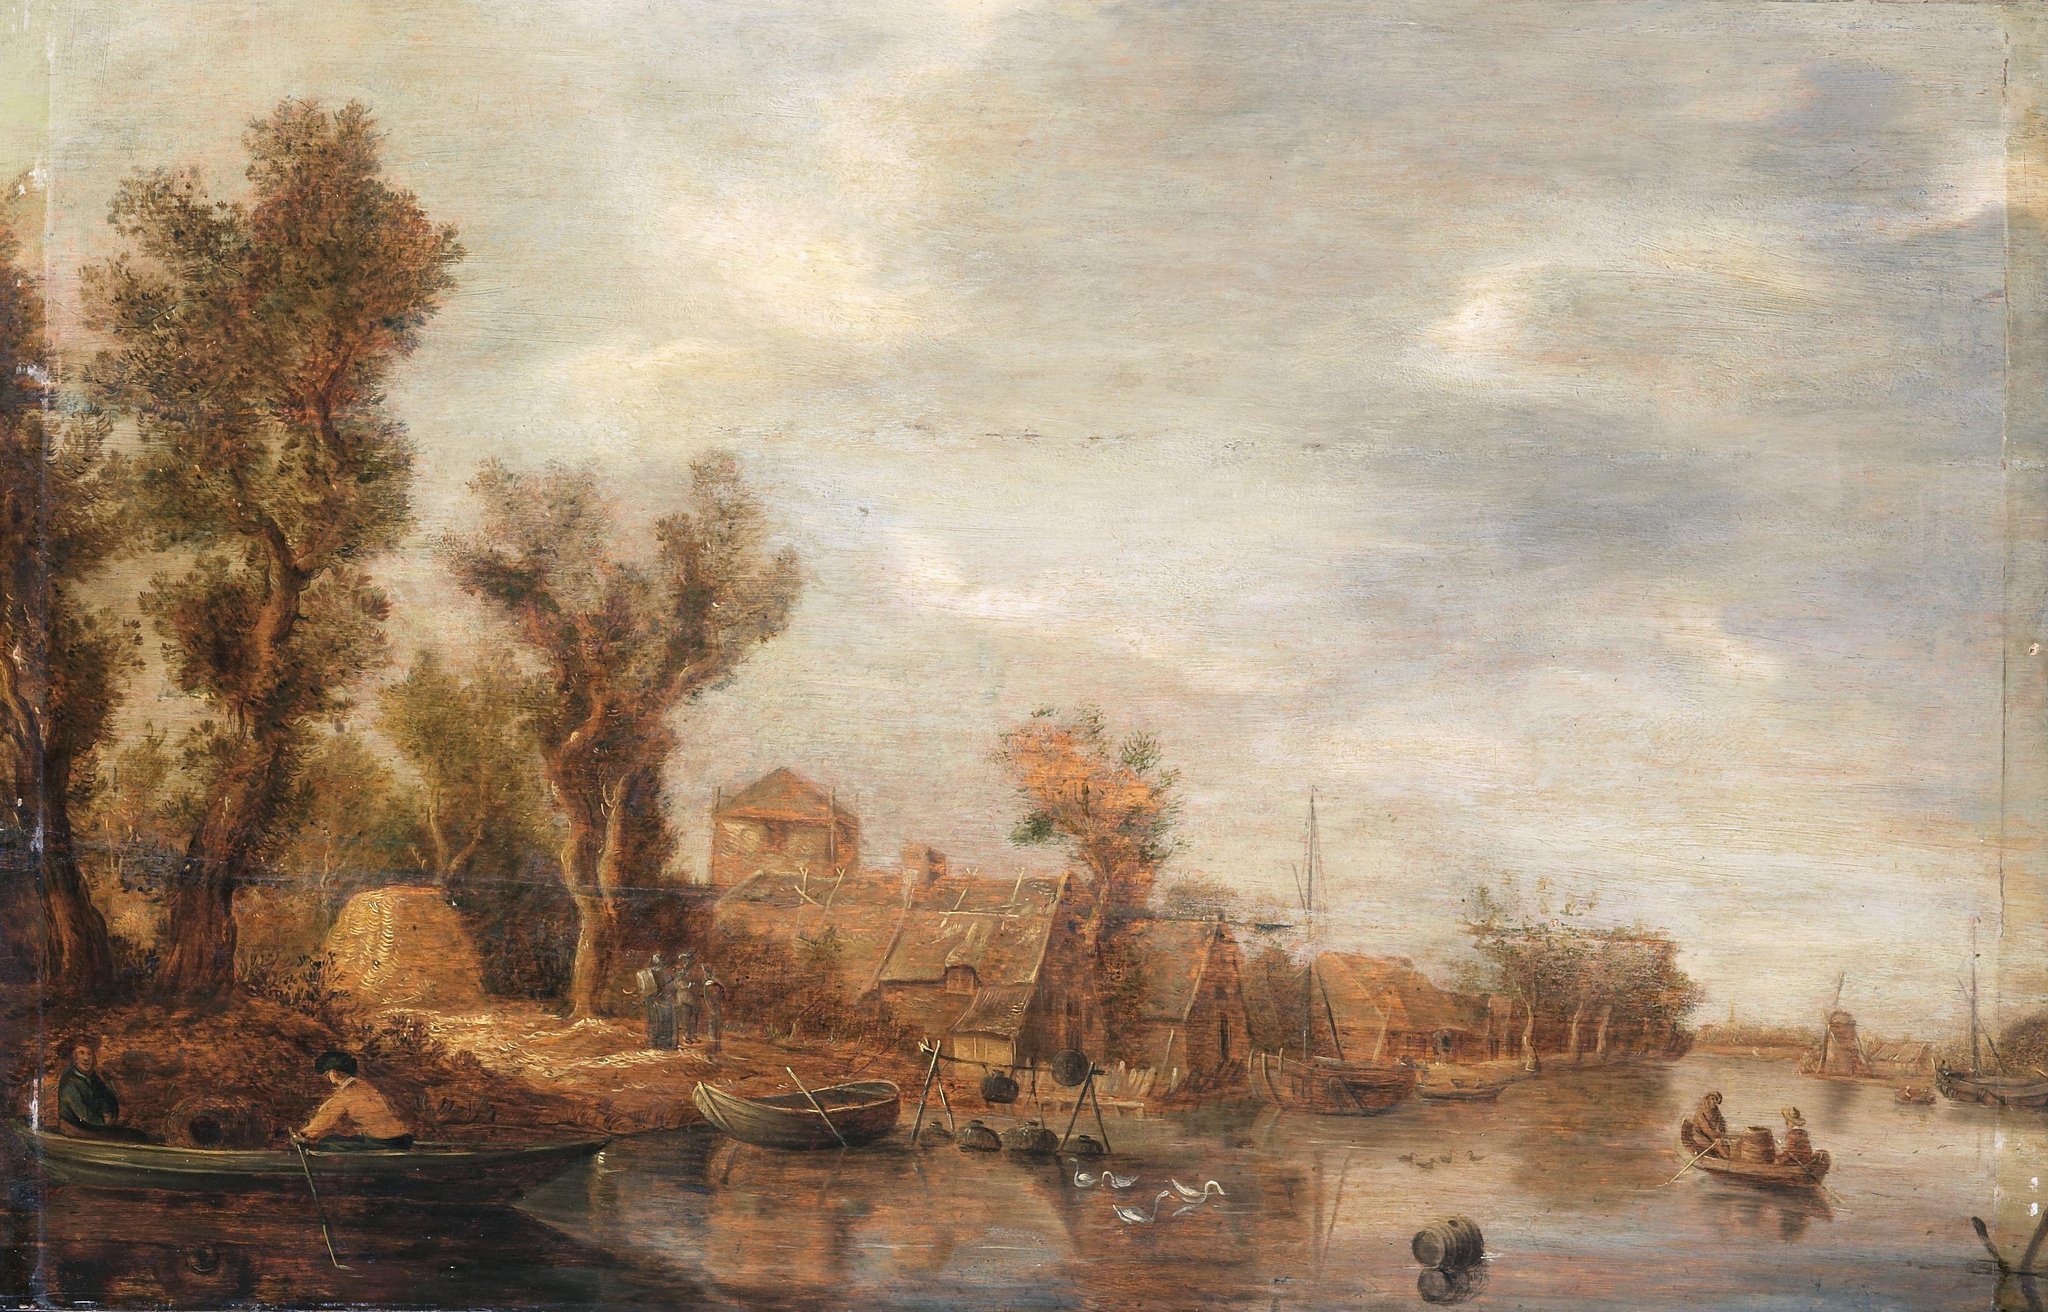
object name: painting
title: River View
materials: oil, panel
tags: canals, waters (in village)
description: Riviergezicht met links tussen bomen de huizen van een dorp. Op de voorgrond enkele figuren in roeibootjes op het water.